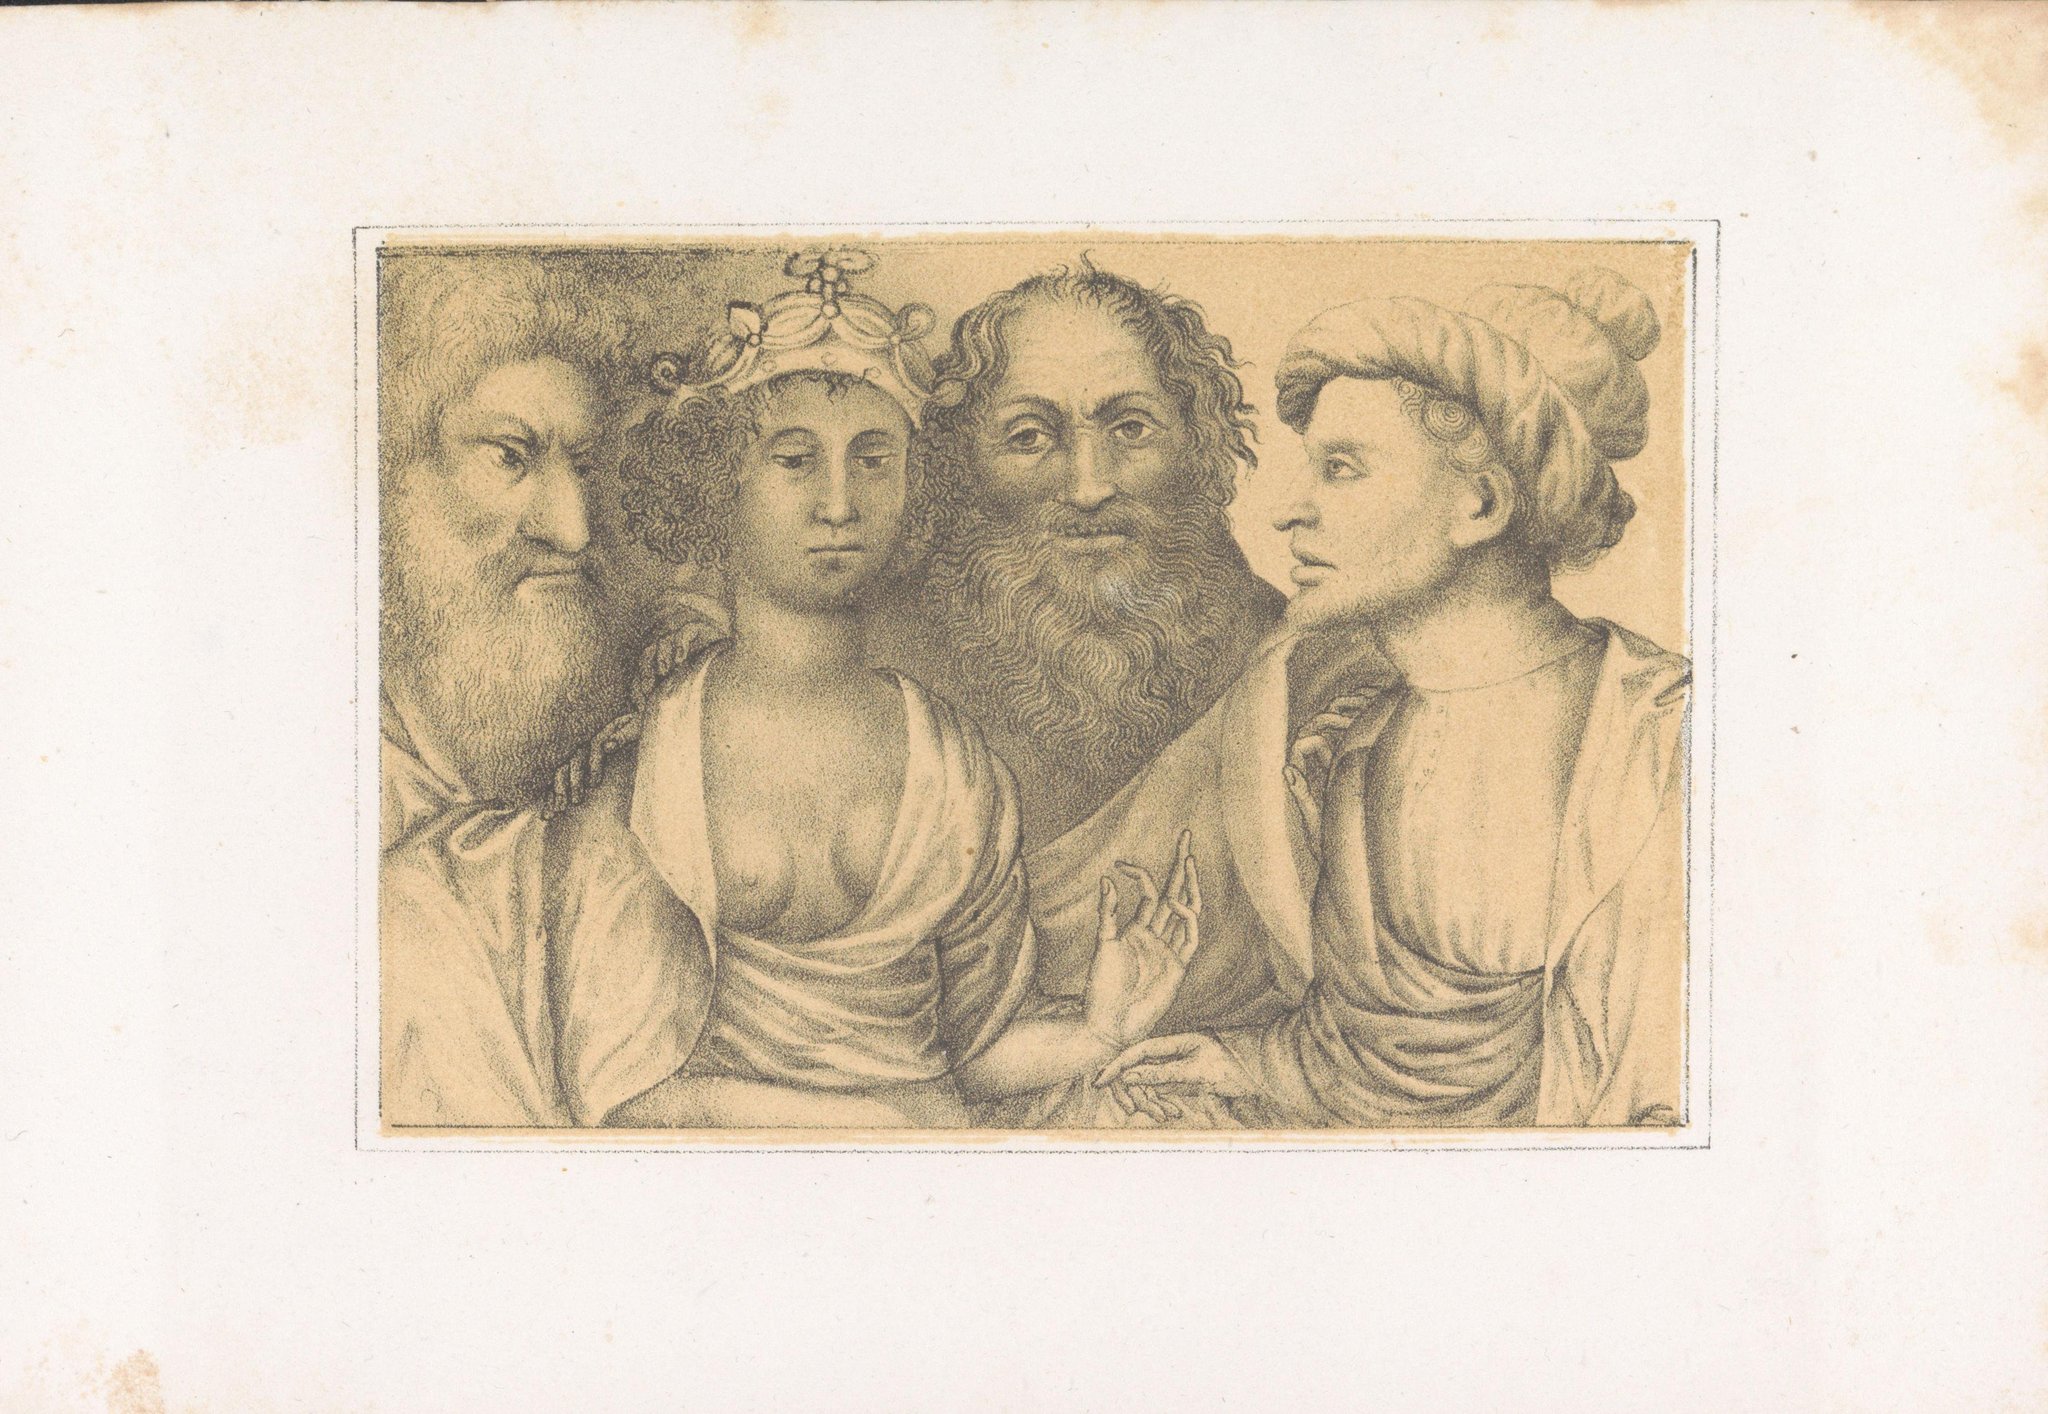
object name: print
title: Entwürfe und Studien eines niederländischen Meisters aus dem XV. Jahrhundert. Nach den in der Königlichen Bibliothek zu Berlin aufbewahrten Originalen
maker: karl palzow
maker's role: print maker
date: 1830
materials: paper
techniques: tone lithography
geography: berlin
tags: adolescent, young woman, maiden, youth, adolescent, old man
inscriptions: collector's mark: Lugt 2228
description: Twee oude mannen vereniging een jonge vrouw en jonge man. De vrouw draagt een kroon op het hoofd. Prent is onderdeel van een omslag met tekst en een serie van achttien lithografieën naar schilderijen van Nederlandse meesters.